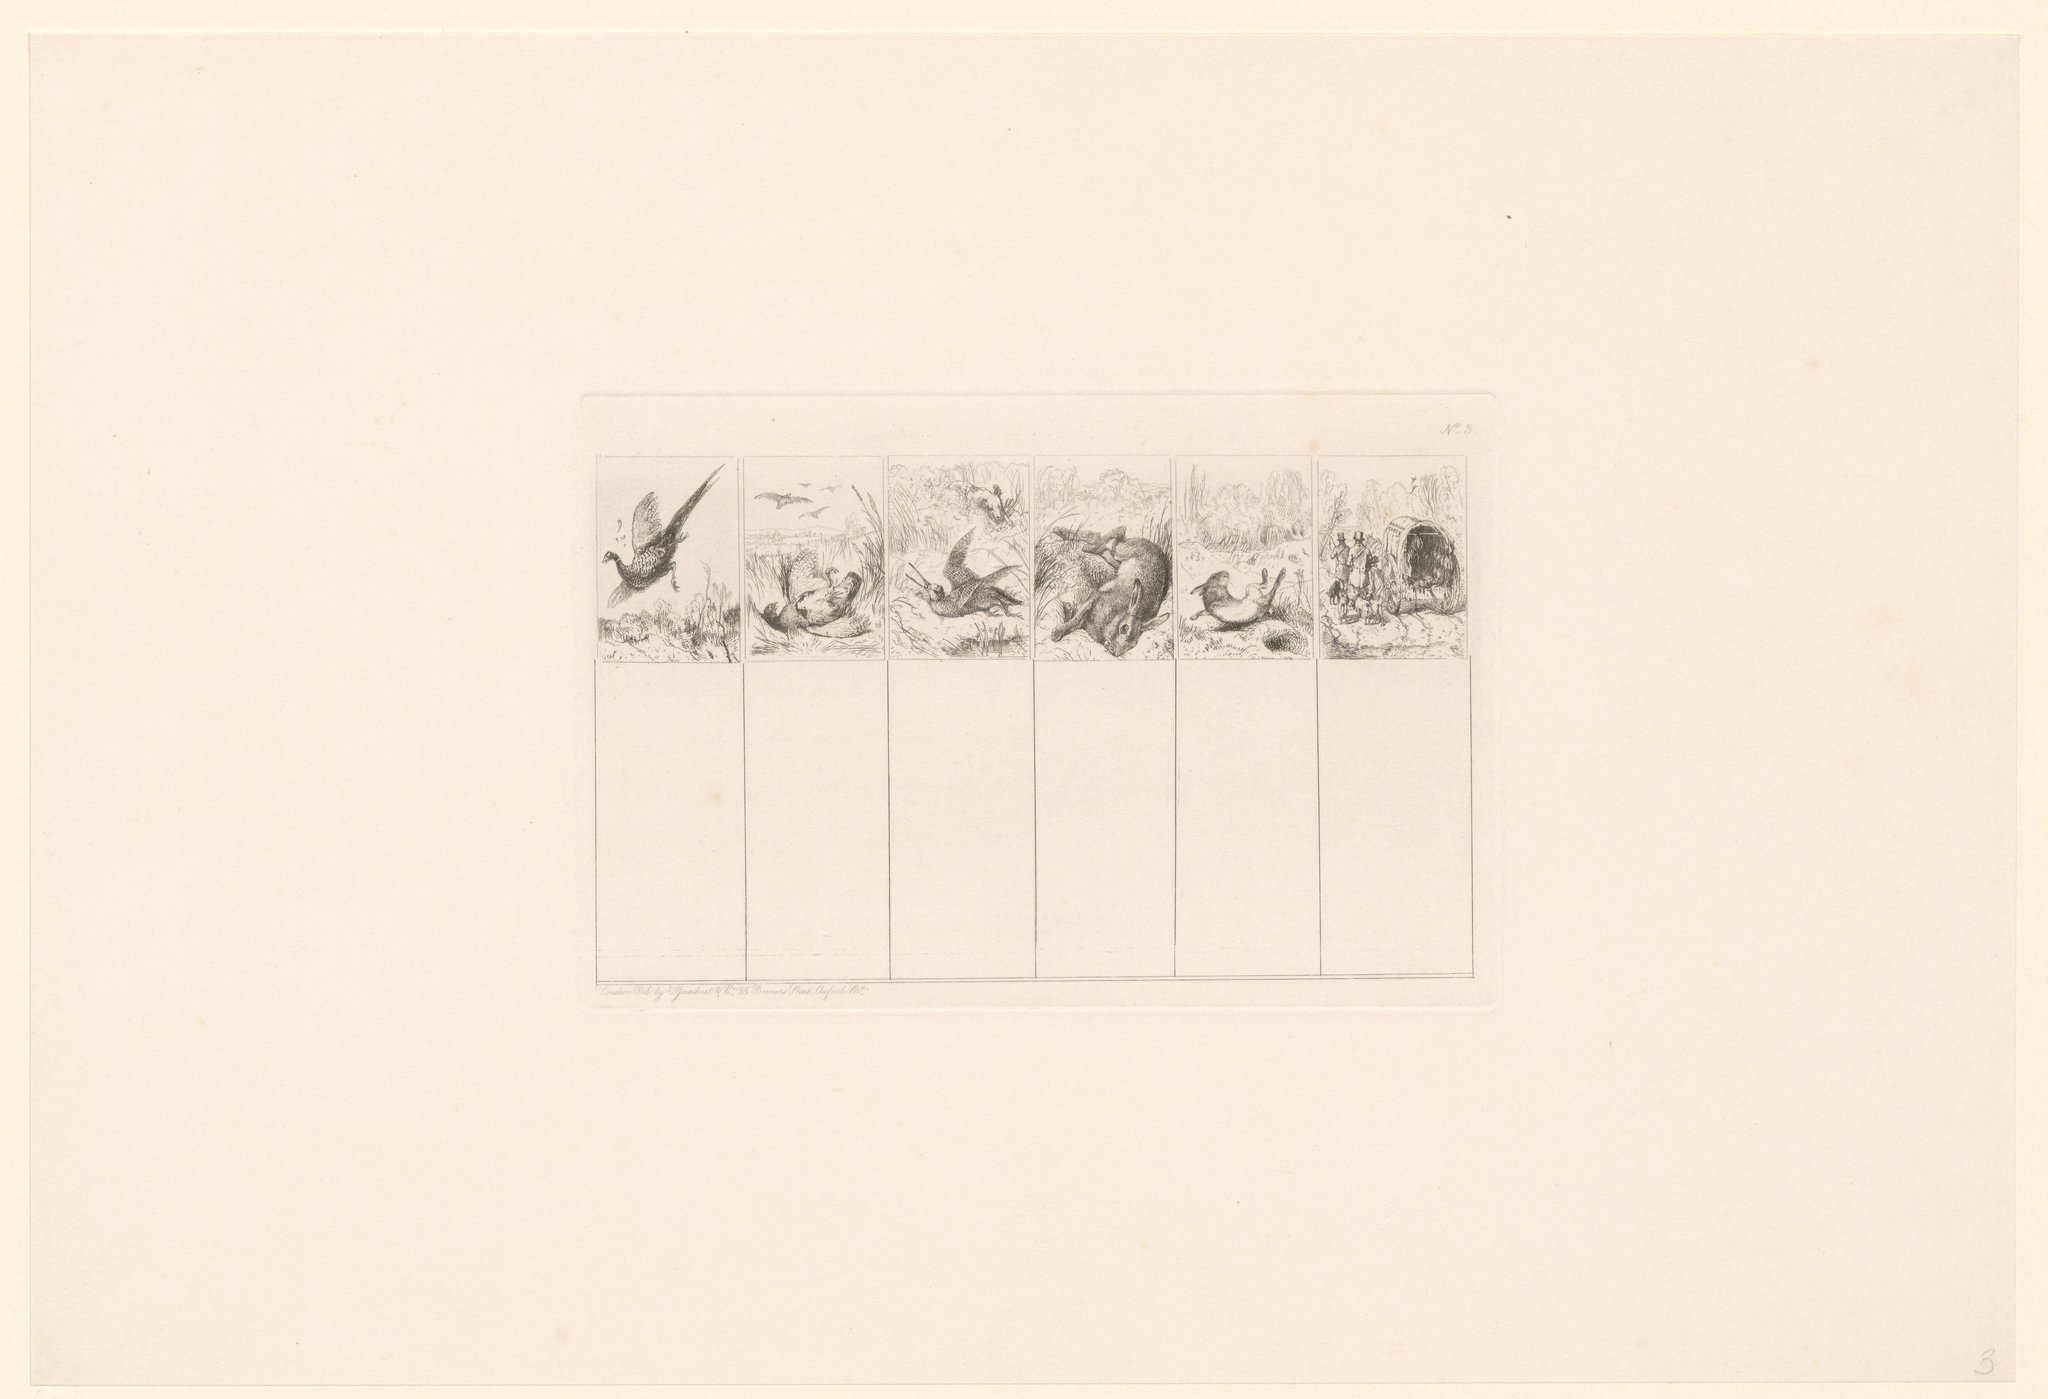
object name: print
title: Landschappen met jachthonden, wild en jagers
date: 1848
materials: paper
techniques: etching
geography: london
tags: rodents: hare, game, hunted animals, walker and runner birds: pheasant, spoils of the hunt, game, venison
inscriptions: check stamp: Lugt 4736, collector's mark: Lugt 2228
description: Deze prent was mogelijk bedoeld als kaart om de opbrengst van de jacht op te turven.